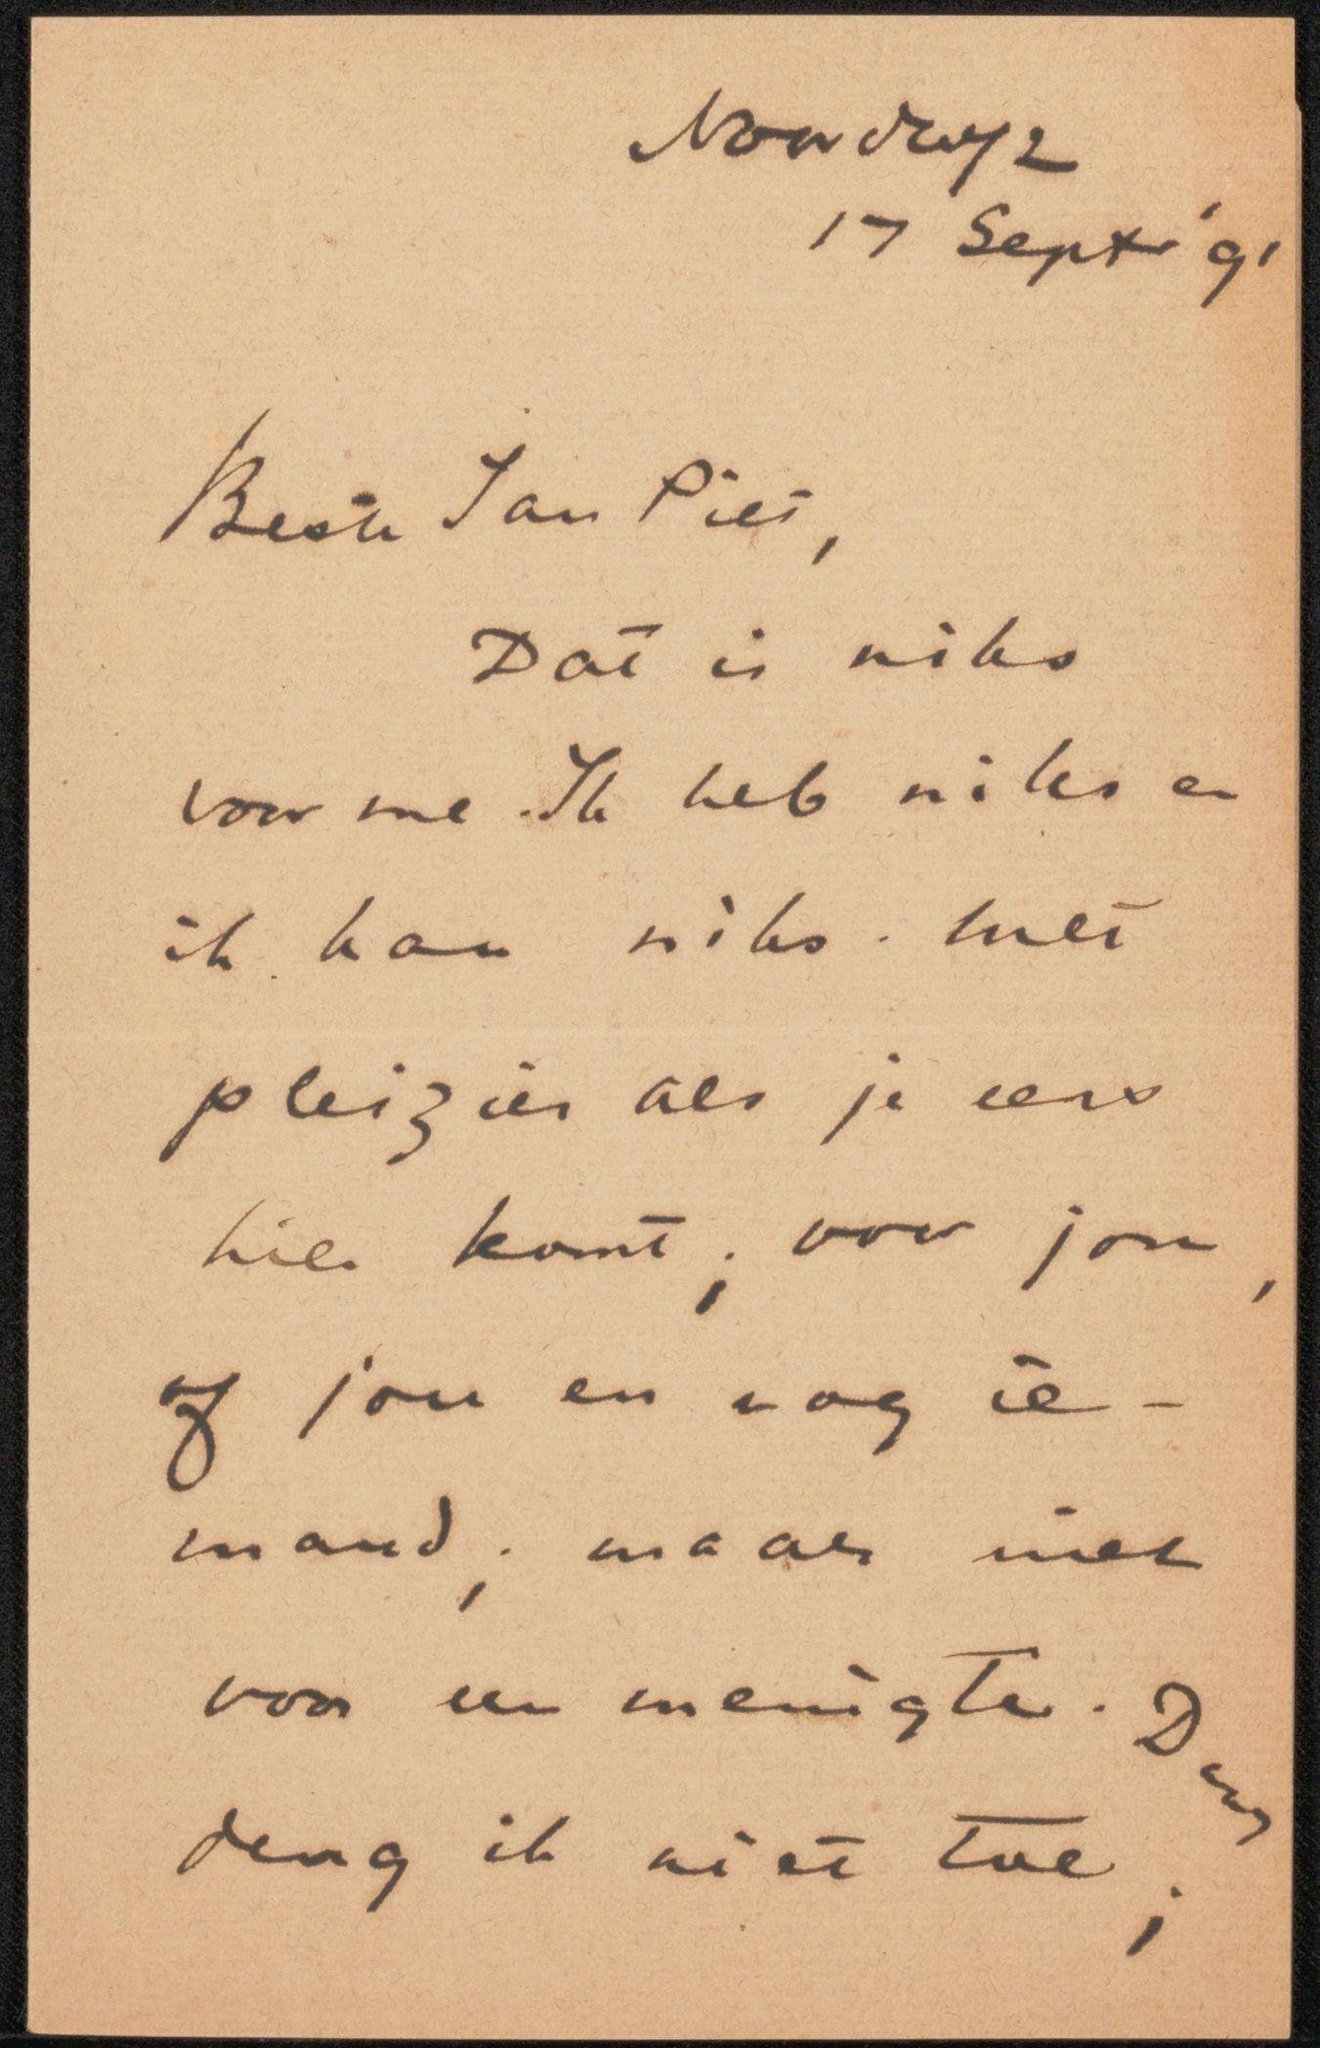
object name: letter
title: Brief aan Jan Veth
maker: albert verwey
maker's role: criticus, dichter, essayist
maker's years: 1865-1937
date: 1891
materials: ink, paper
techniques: pen, writing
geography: noordwijk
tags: dordrecht, designer, jan veth, the hague, painter, print maker, draughtsman, jan toorop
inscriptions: collector's mark: ‘RPK’